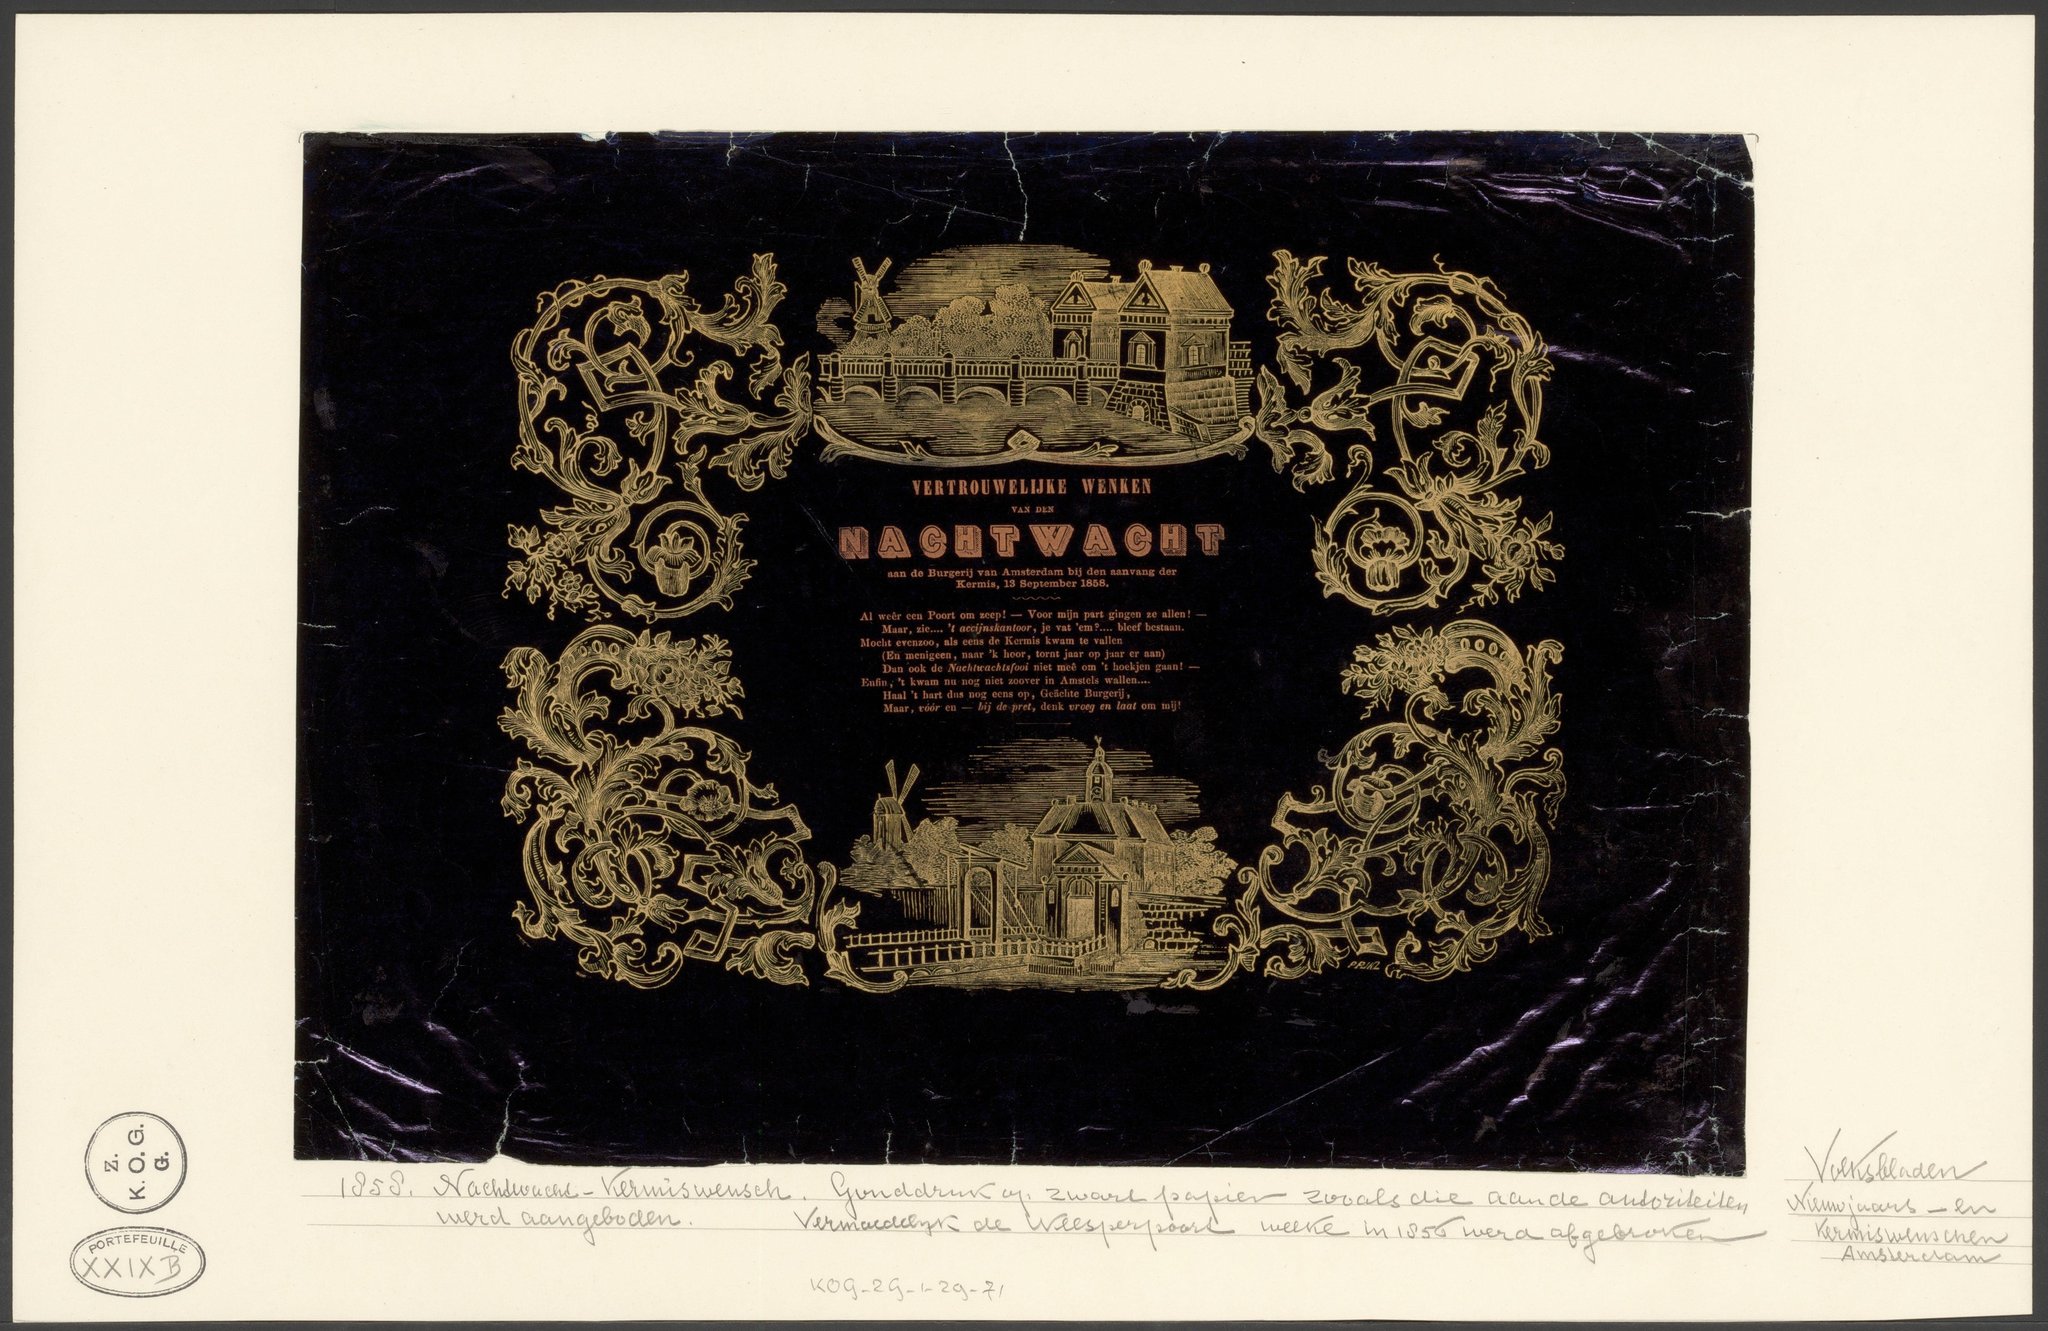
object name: fair print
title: Kermisprent van de Amsterdamse nachtwacht voor het jaar 1858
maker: friedrich robert prinz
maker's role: print maker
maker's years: 1820-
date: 1858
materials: paper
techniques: engraving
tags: night patrol, city-gate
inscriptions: collector's mark: Lugt 1641, stamp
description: Kermisprent van de Amsterdamse nachtwacht (ratelwacht), 13 september 1858. Boven en onder voorstellingen van de Weesperpoort en Muiderpoort te Amsterdam, links en rechts bladranken. Centraal een gedicht. Onderwerpsrubrieken binnen de Atlas Zeden en Gewoonten: Zeden en gewoonten in engeren zin, Volksleven, Volksbladen, Nieuwjaars- en Kerstwenschen, Amsterdam.